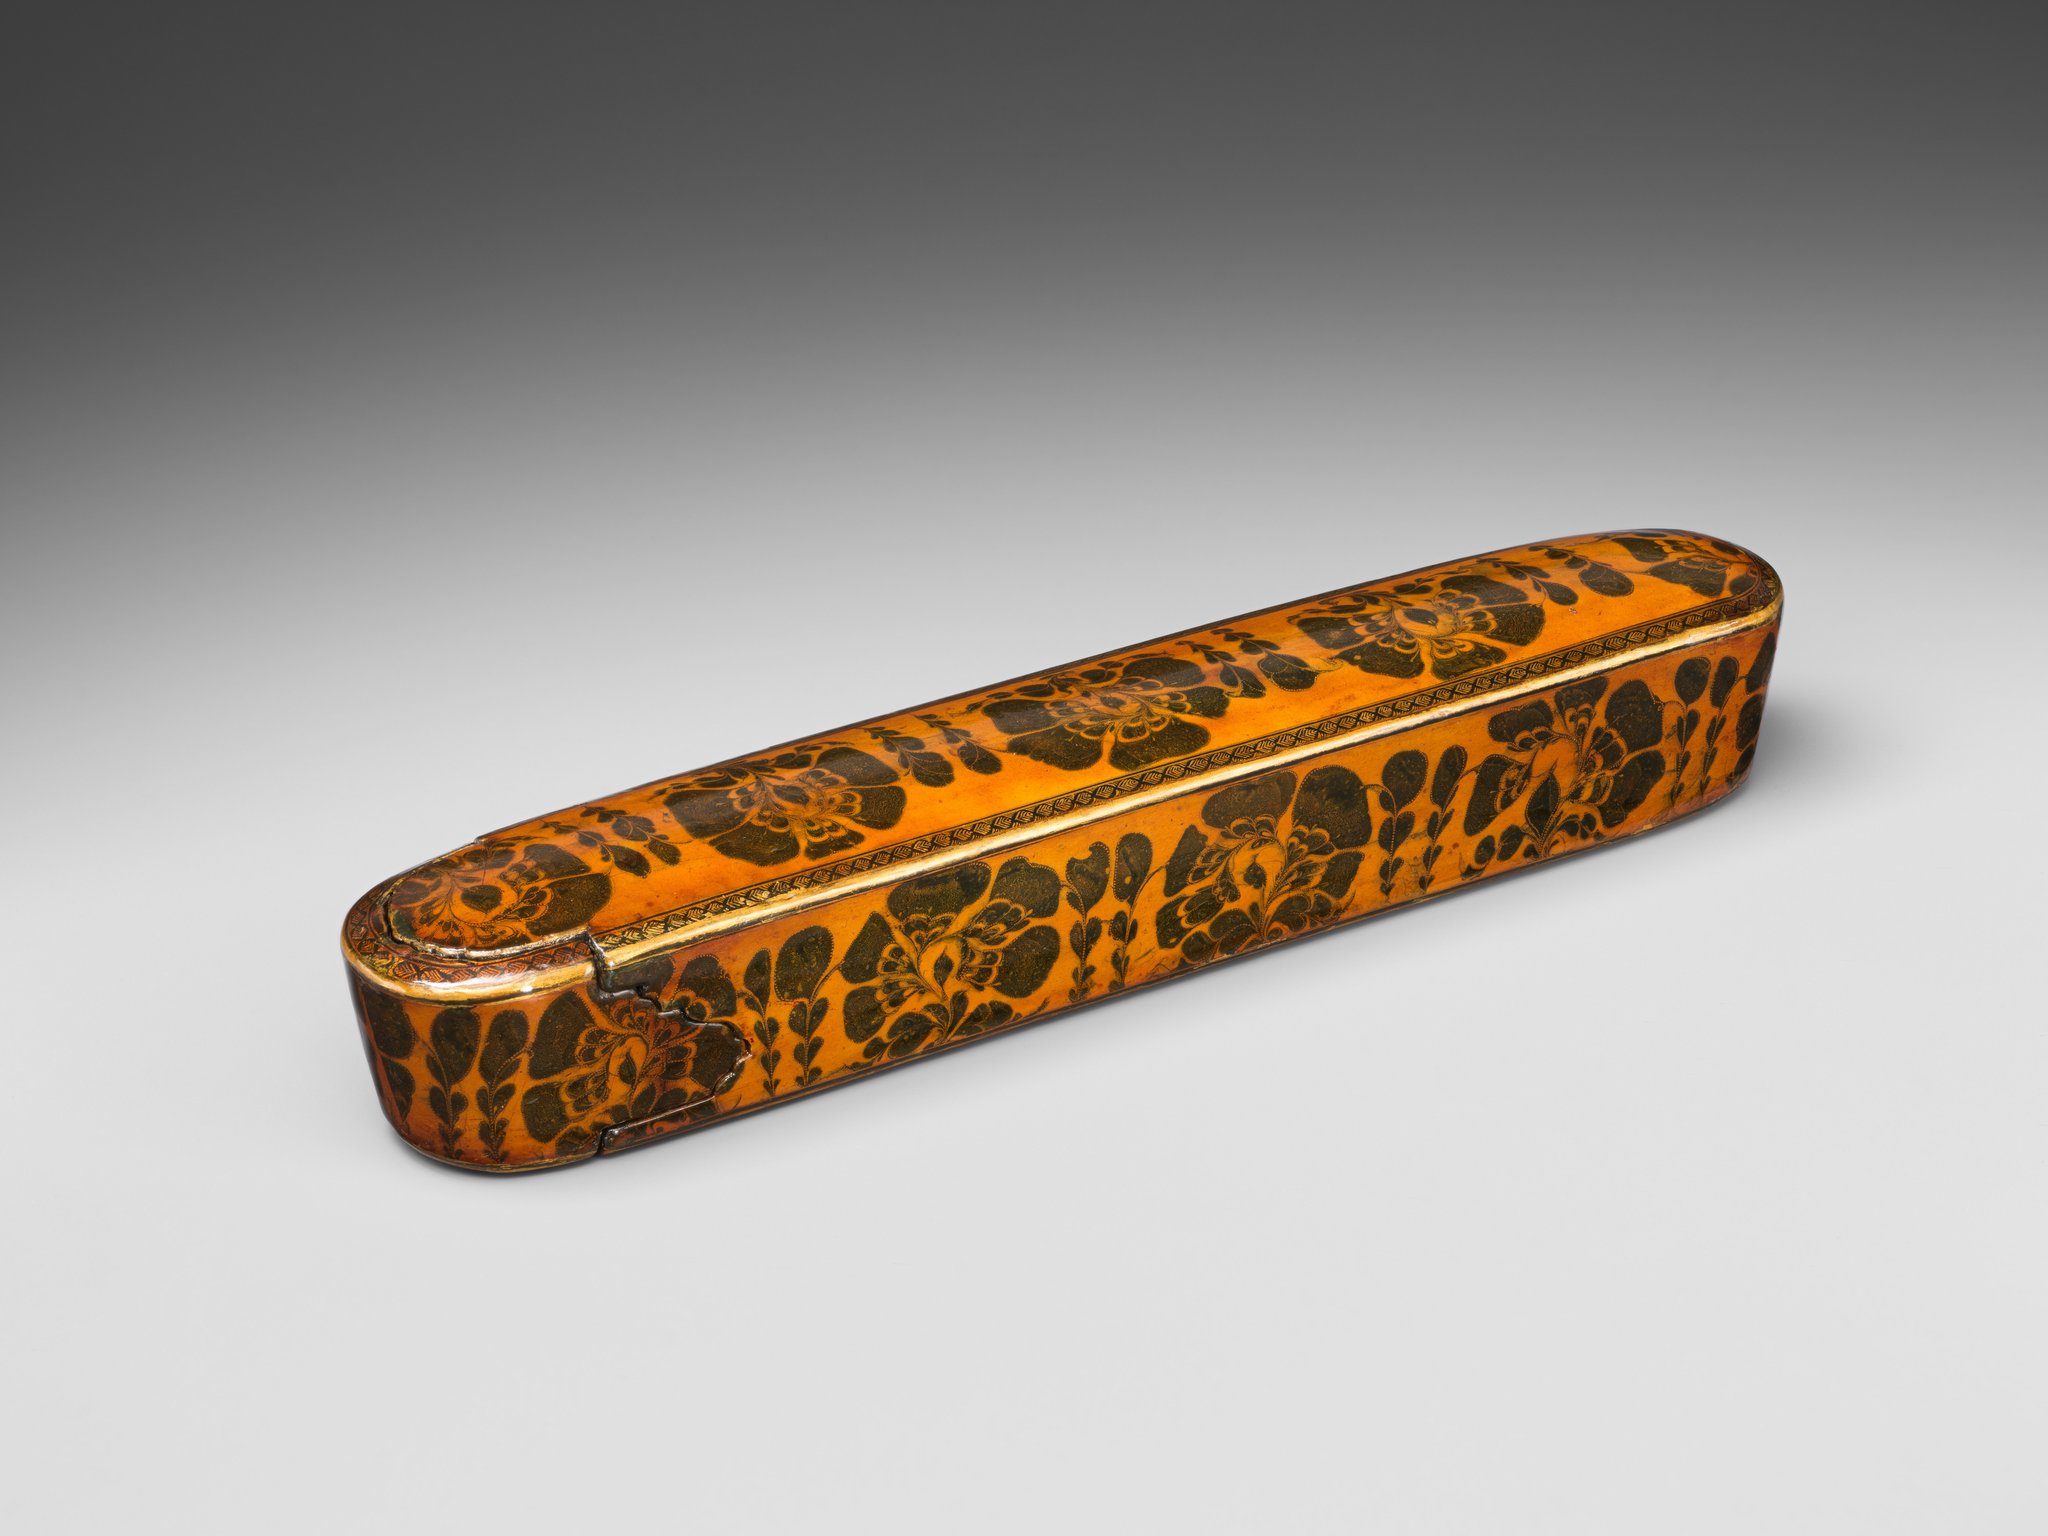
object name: pen box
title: Pen Box attributed to Muhammad ibn Muhammad Mahdi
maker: muhammad ibn muhammad mahdi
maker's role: artist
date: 1801-1833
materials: paper, varnish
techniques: gilding, painting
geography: iran